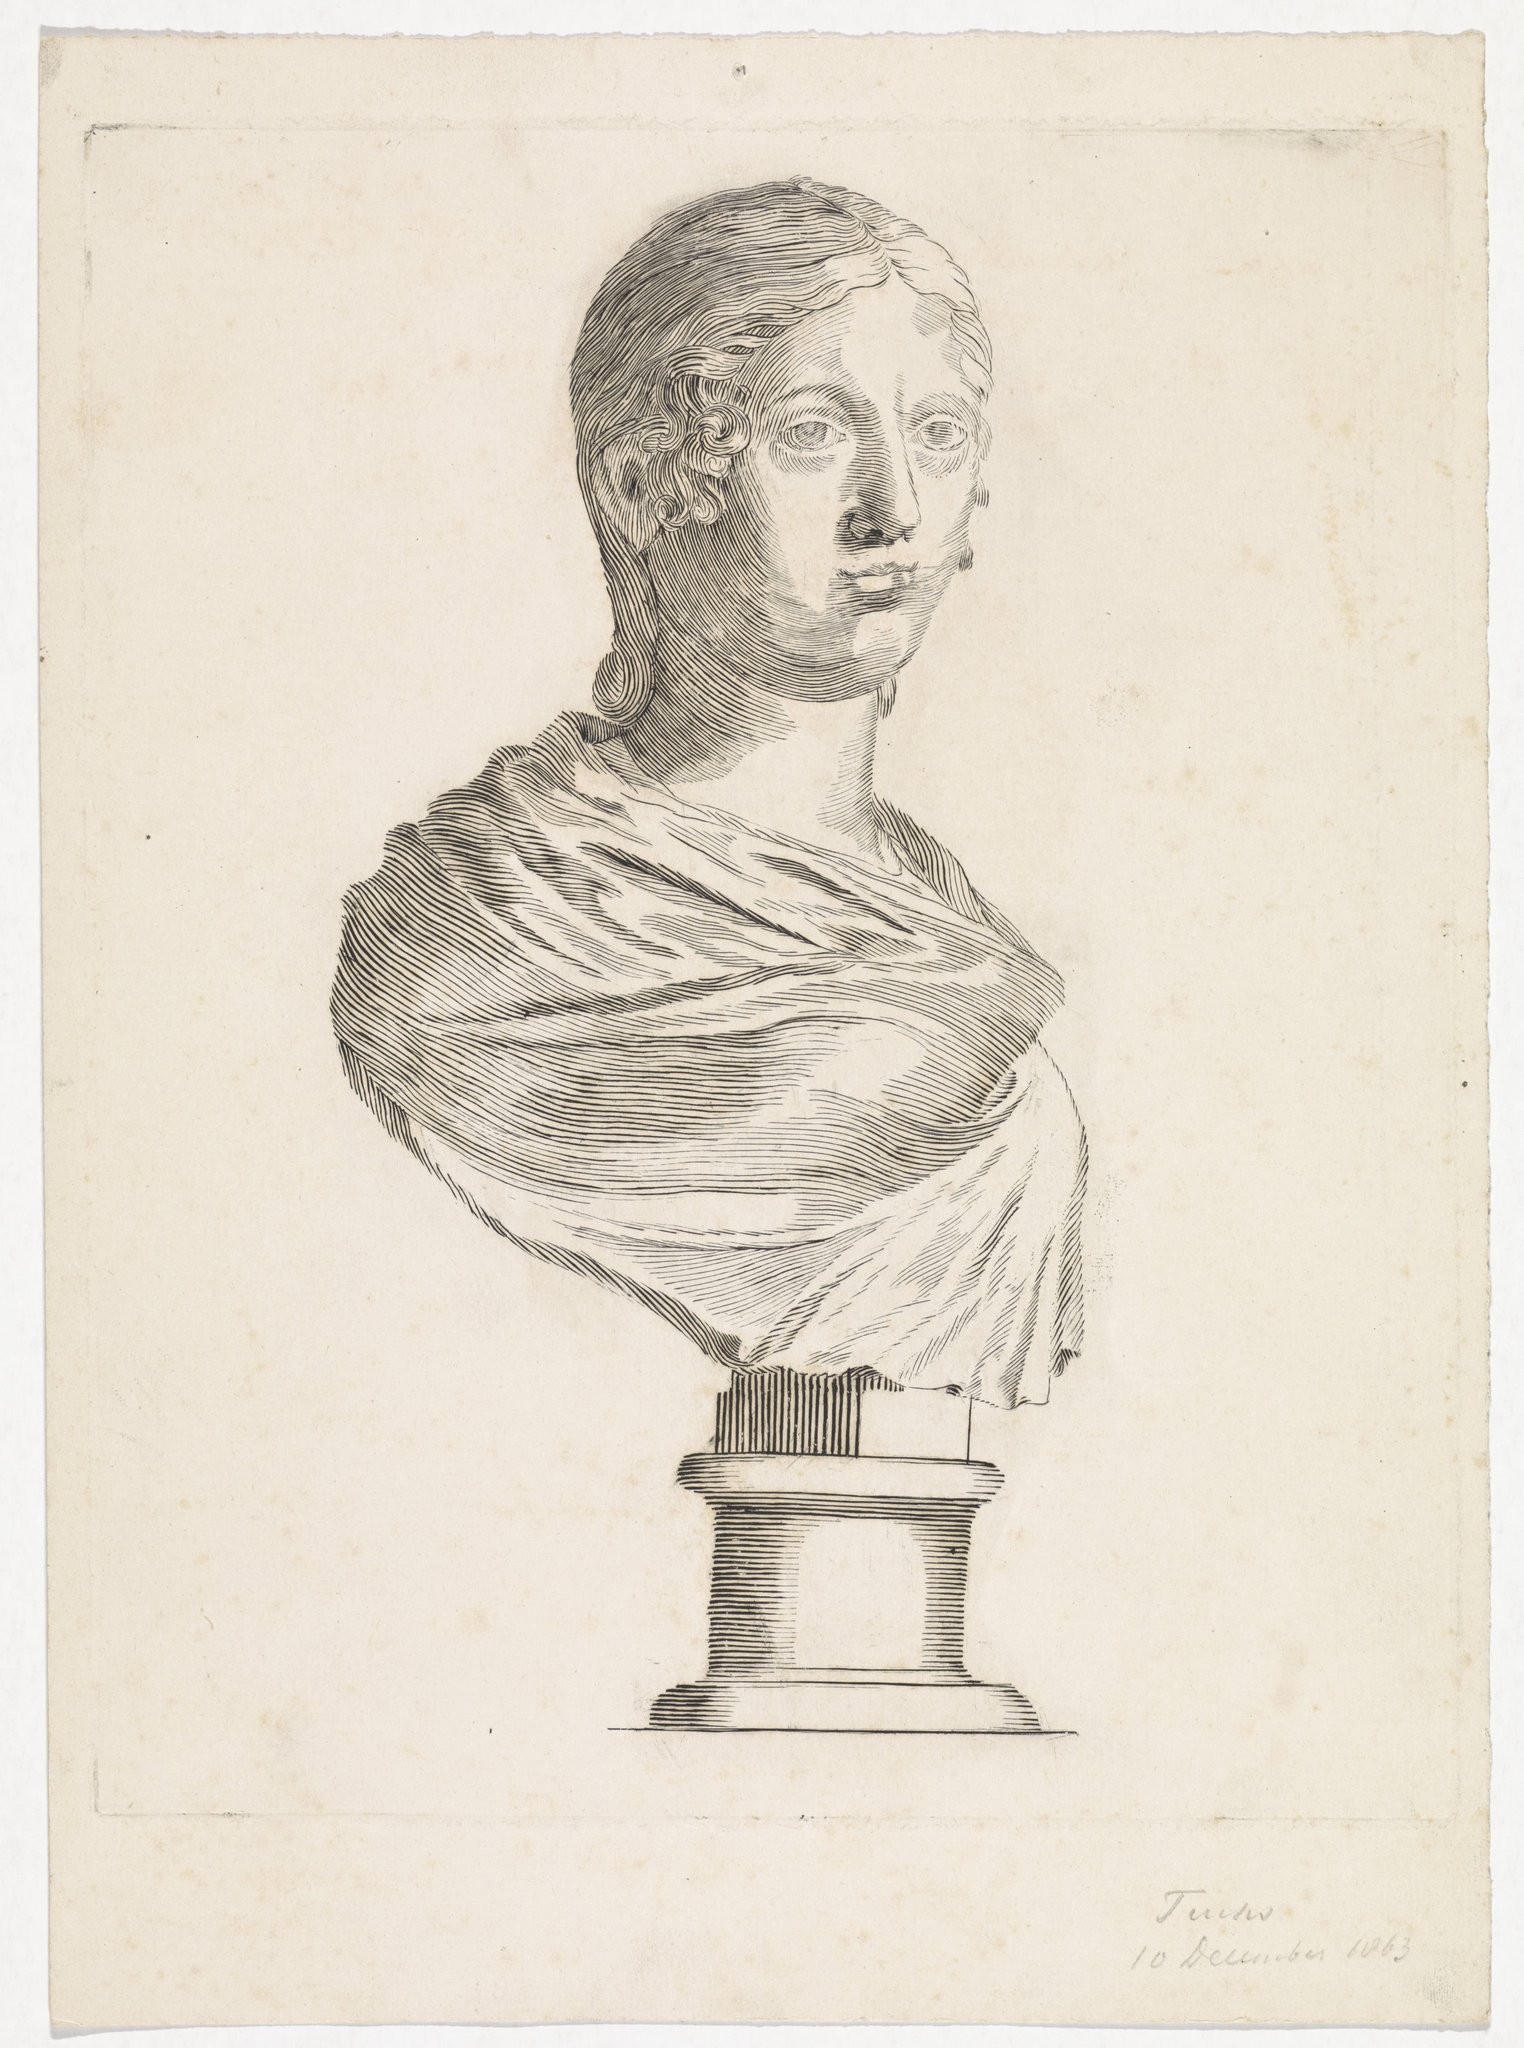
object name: print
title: Buste van een vrouw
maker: c.a. tuchs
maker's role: print maker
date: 1863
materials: paper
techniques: engraving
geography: netherlands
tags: piece of sculpture, reproduction of a piece of sculpture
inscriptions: inscription: ‘Tuchs 10 December 1863’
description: Portretbuste van een vrouw, naar een sculptuur.